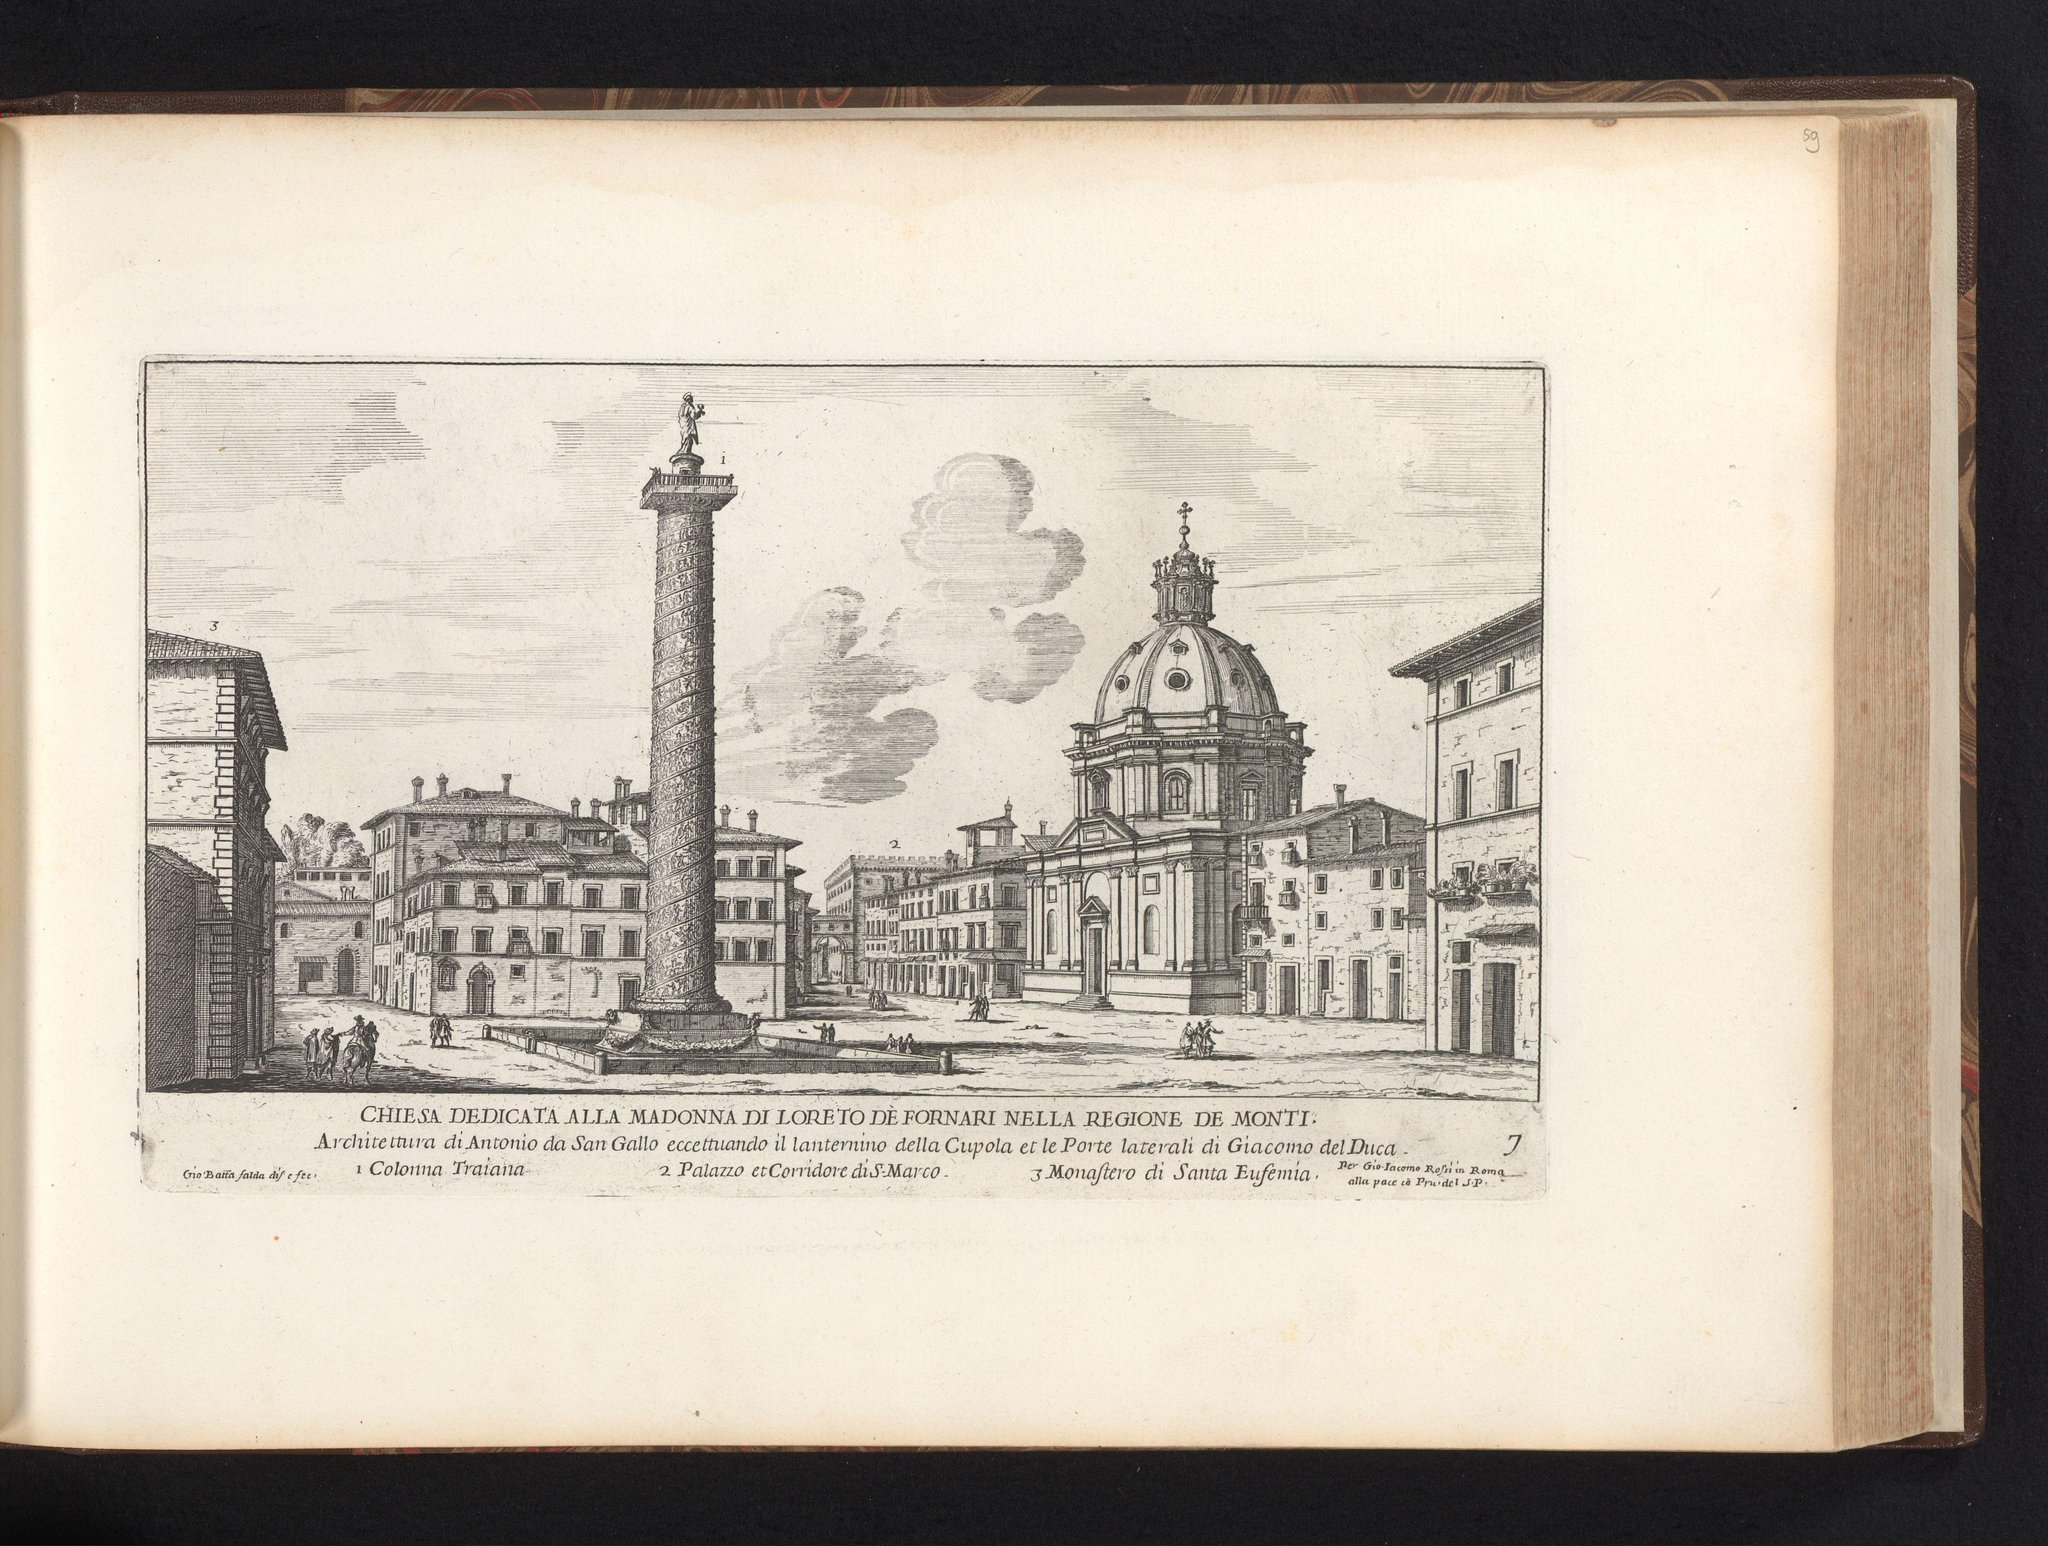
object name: album leaf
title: Chiesa dedicata alla Madonna di Loreto de fornari nella Regione de Monti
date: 1669-1670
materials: paper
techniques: etching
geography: vatican city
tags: square, place, circus, etc., city-view, and landscape with man-made constructions, church (exterior), triumphal column with helical friezes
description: Deze titelprent maakt deel uit van een reeks van 38 prenten met voorstellingen van kerken in Rome. Samen met vier andere reeksen vormt het de grote reeks: 'Il nuovo teatro di Roma moderna'.